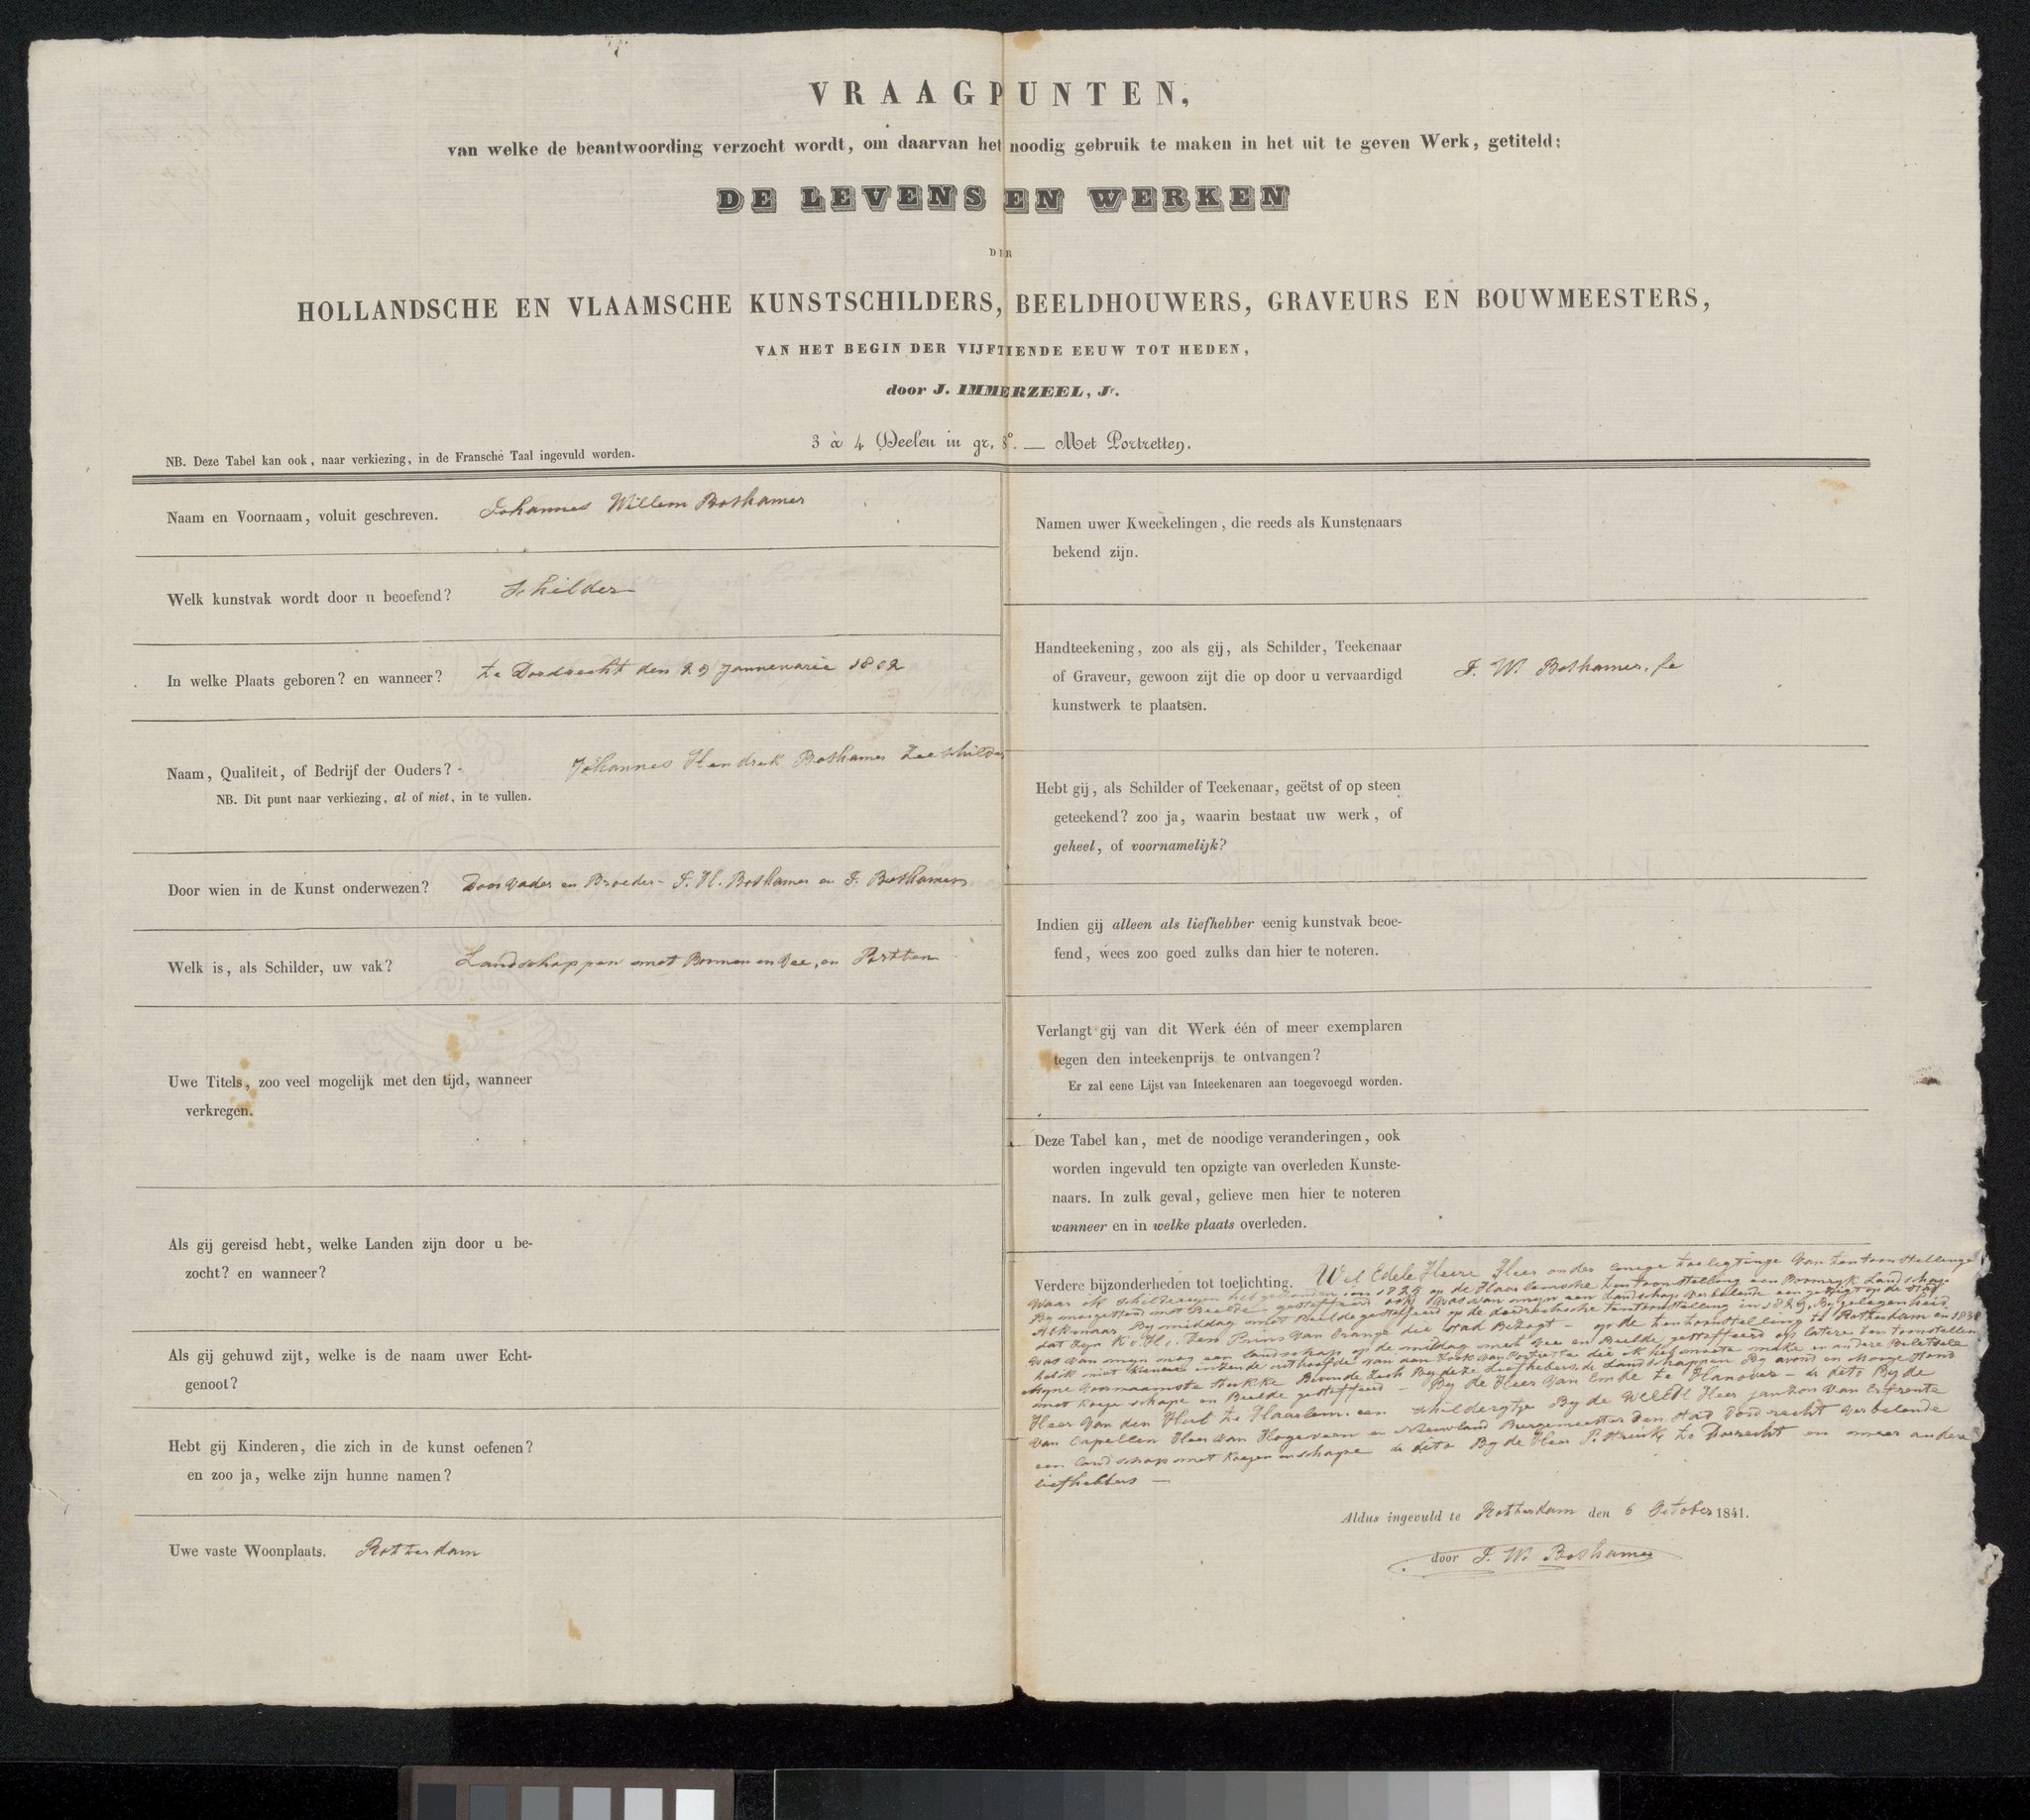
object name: questionnaire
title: Enquêteformulier ingevuld door Johannes Willem Boshamer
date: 1841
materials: ink, paper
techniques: pen, printing, writing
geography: rotterdam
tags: dordrecht, print maker, draughtsman, johannes willem boshamer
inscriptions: watermark, inscription: ‘Vraagpunten,/ van welke de beantwoording verzocht wordt, om daarvan het noodig gebruik te maken in het uit te geven Werk, getiteld: De levens en werken/ der Hollandsche en Vlaamsche kunstschilders, beeldhouwers,/ graveurs en bouwmeesters, van het begin der vijftiende eeuw tot heden/ door J. Immerzeel, Jr.’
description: Opgenomen in: Immerzeel, J. Jr., De levens en werken der Hollandsche en Vlaamsche kunstschilders, beeldhouwers, graveurs en bouwmeesters, van het begin der vijftiende eeuw tot heden, Amsterdam: J.C. van Kesteren, 1842-1843.